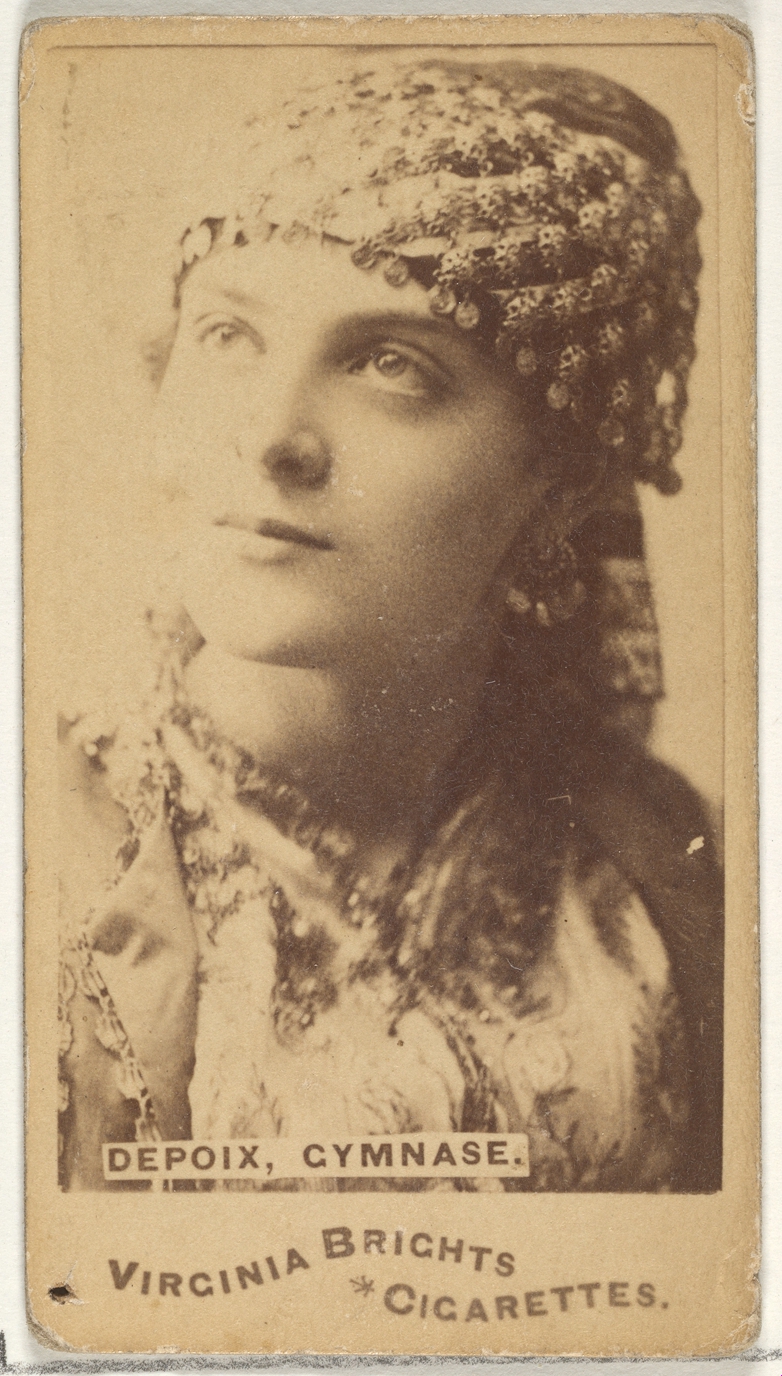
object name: photograph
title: Depoix, Gymnage, from the Actors and Actresses series (N45, Type 1) for Virginia Brights Cigarettes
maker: allen & ginter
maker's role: publisher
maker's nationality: american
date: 1888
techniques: albumen silver print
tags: portraits,women,actresses